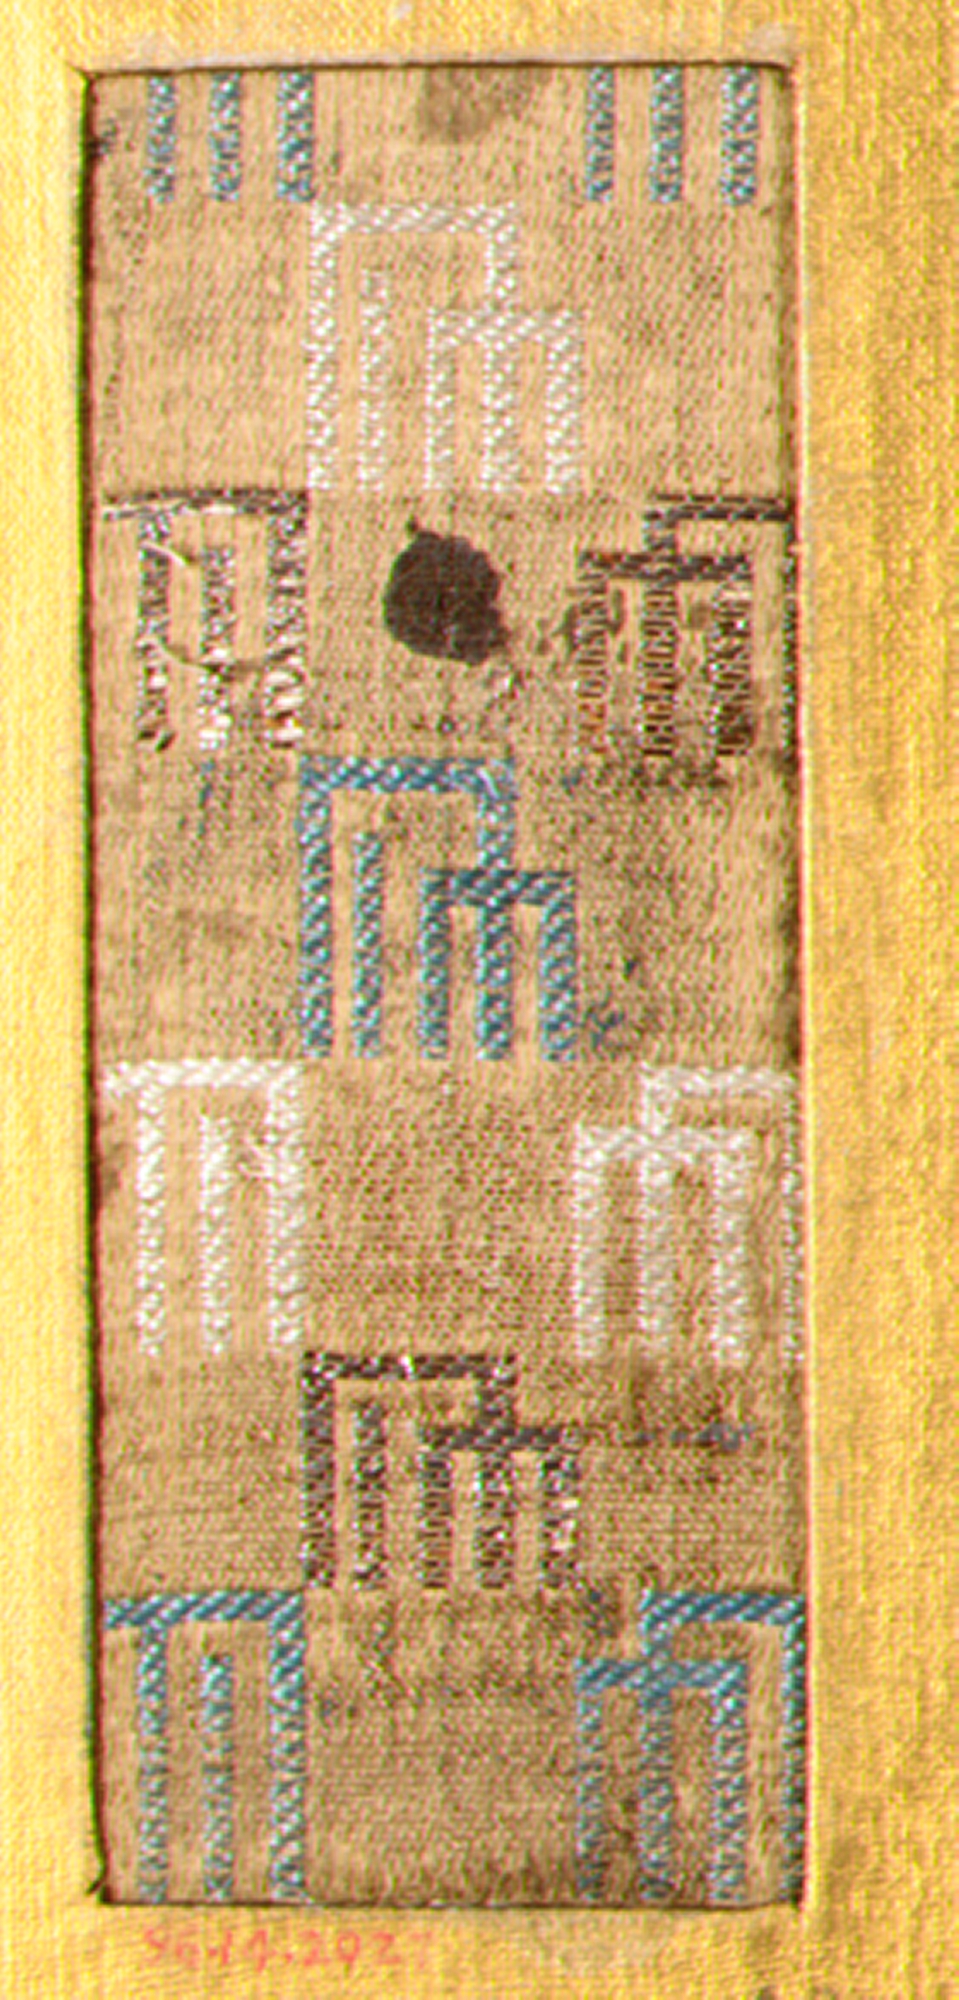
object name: piece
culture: japanese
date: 1701-1900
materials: silk